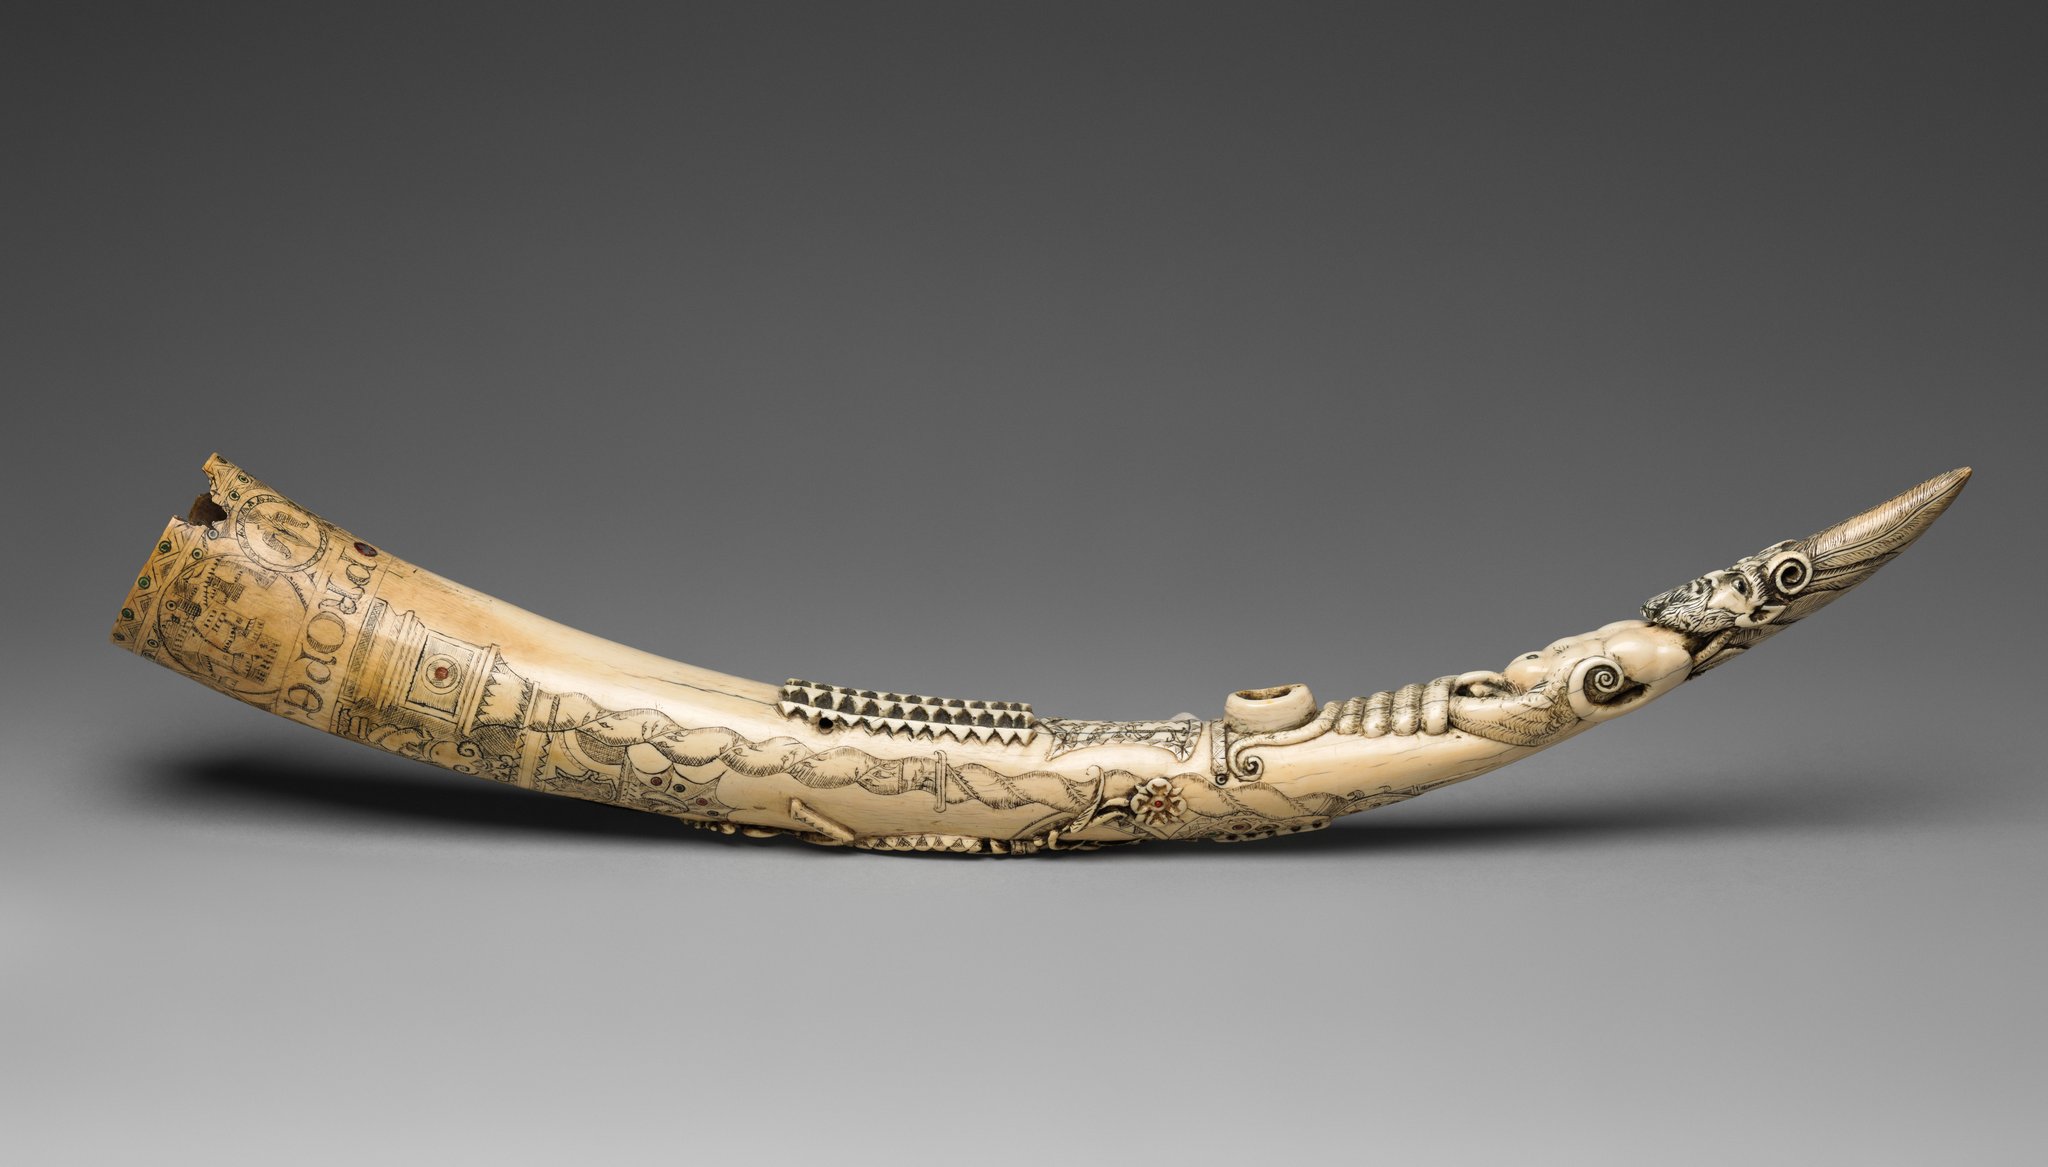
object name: horn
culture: mende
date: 1801-1900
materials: ivory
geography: sierra leone